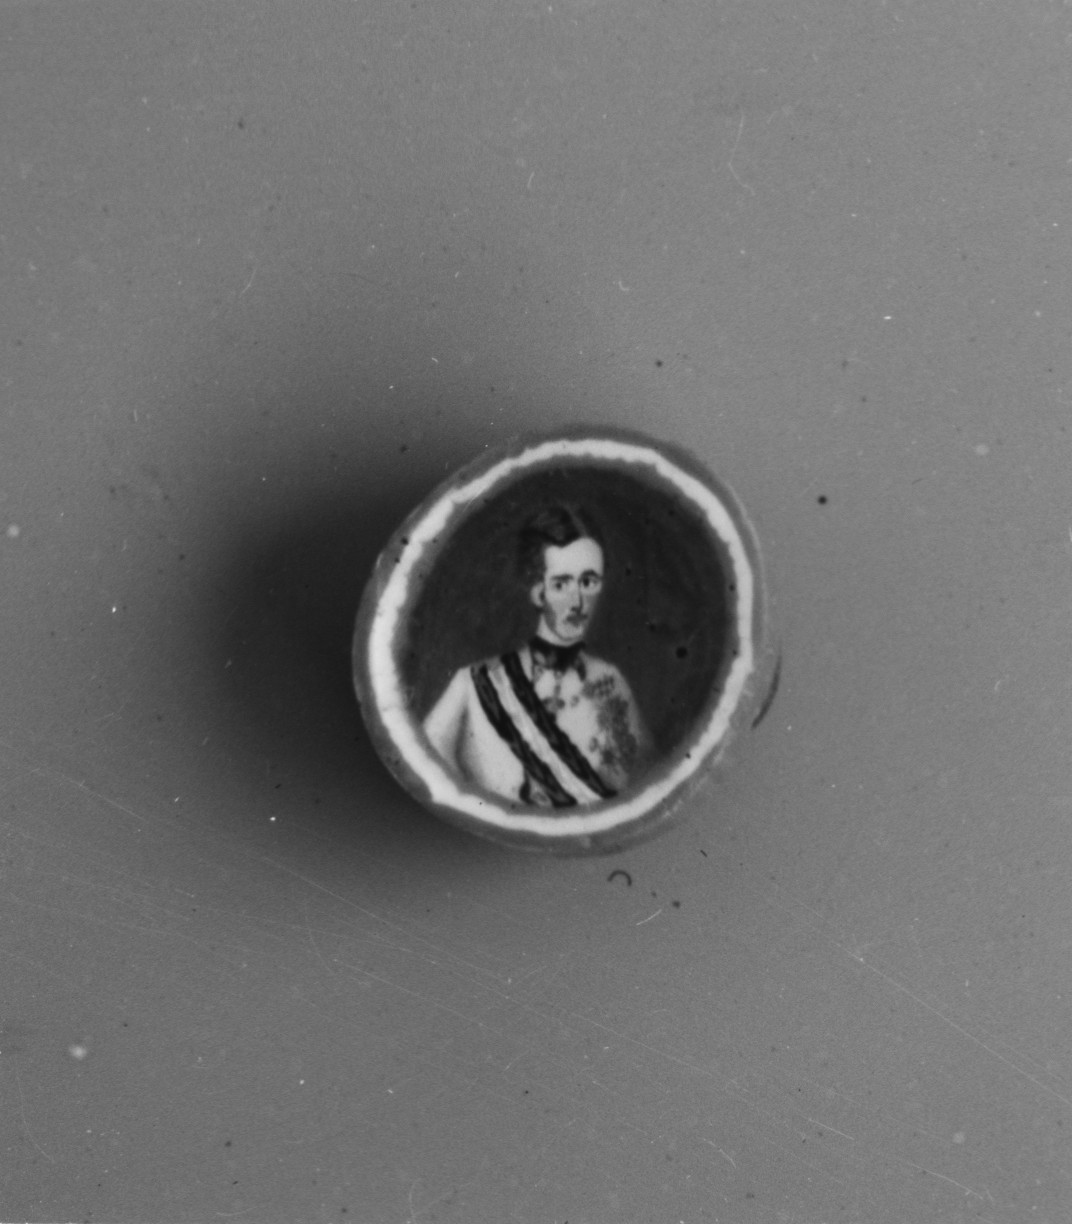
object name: portrait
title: Franz Joseph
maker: franchini co.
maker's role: manufacturer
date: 1846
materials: glass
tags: men,portraits